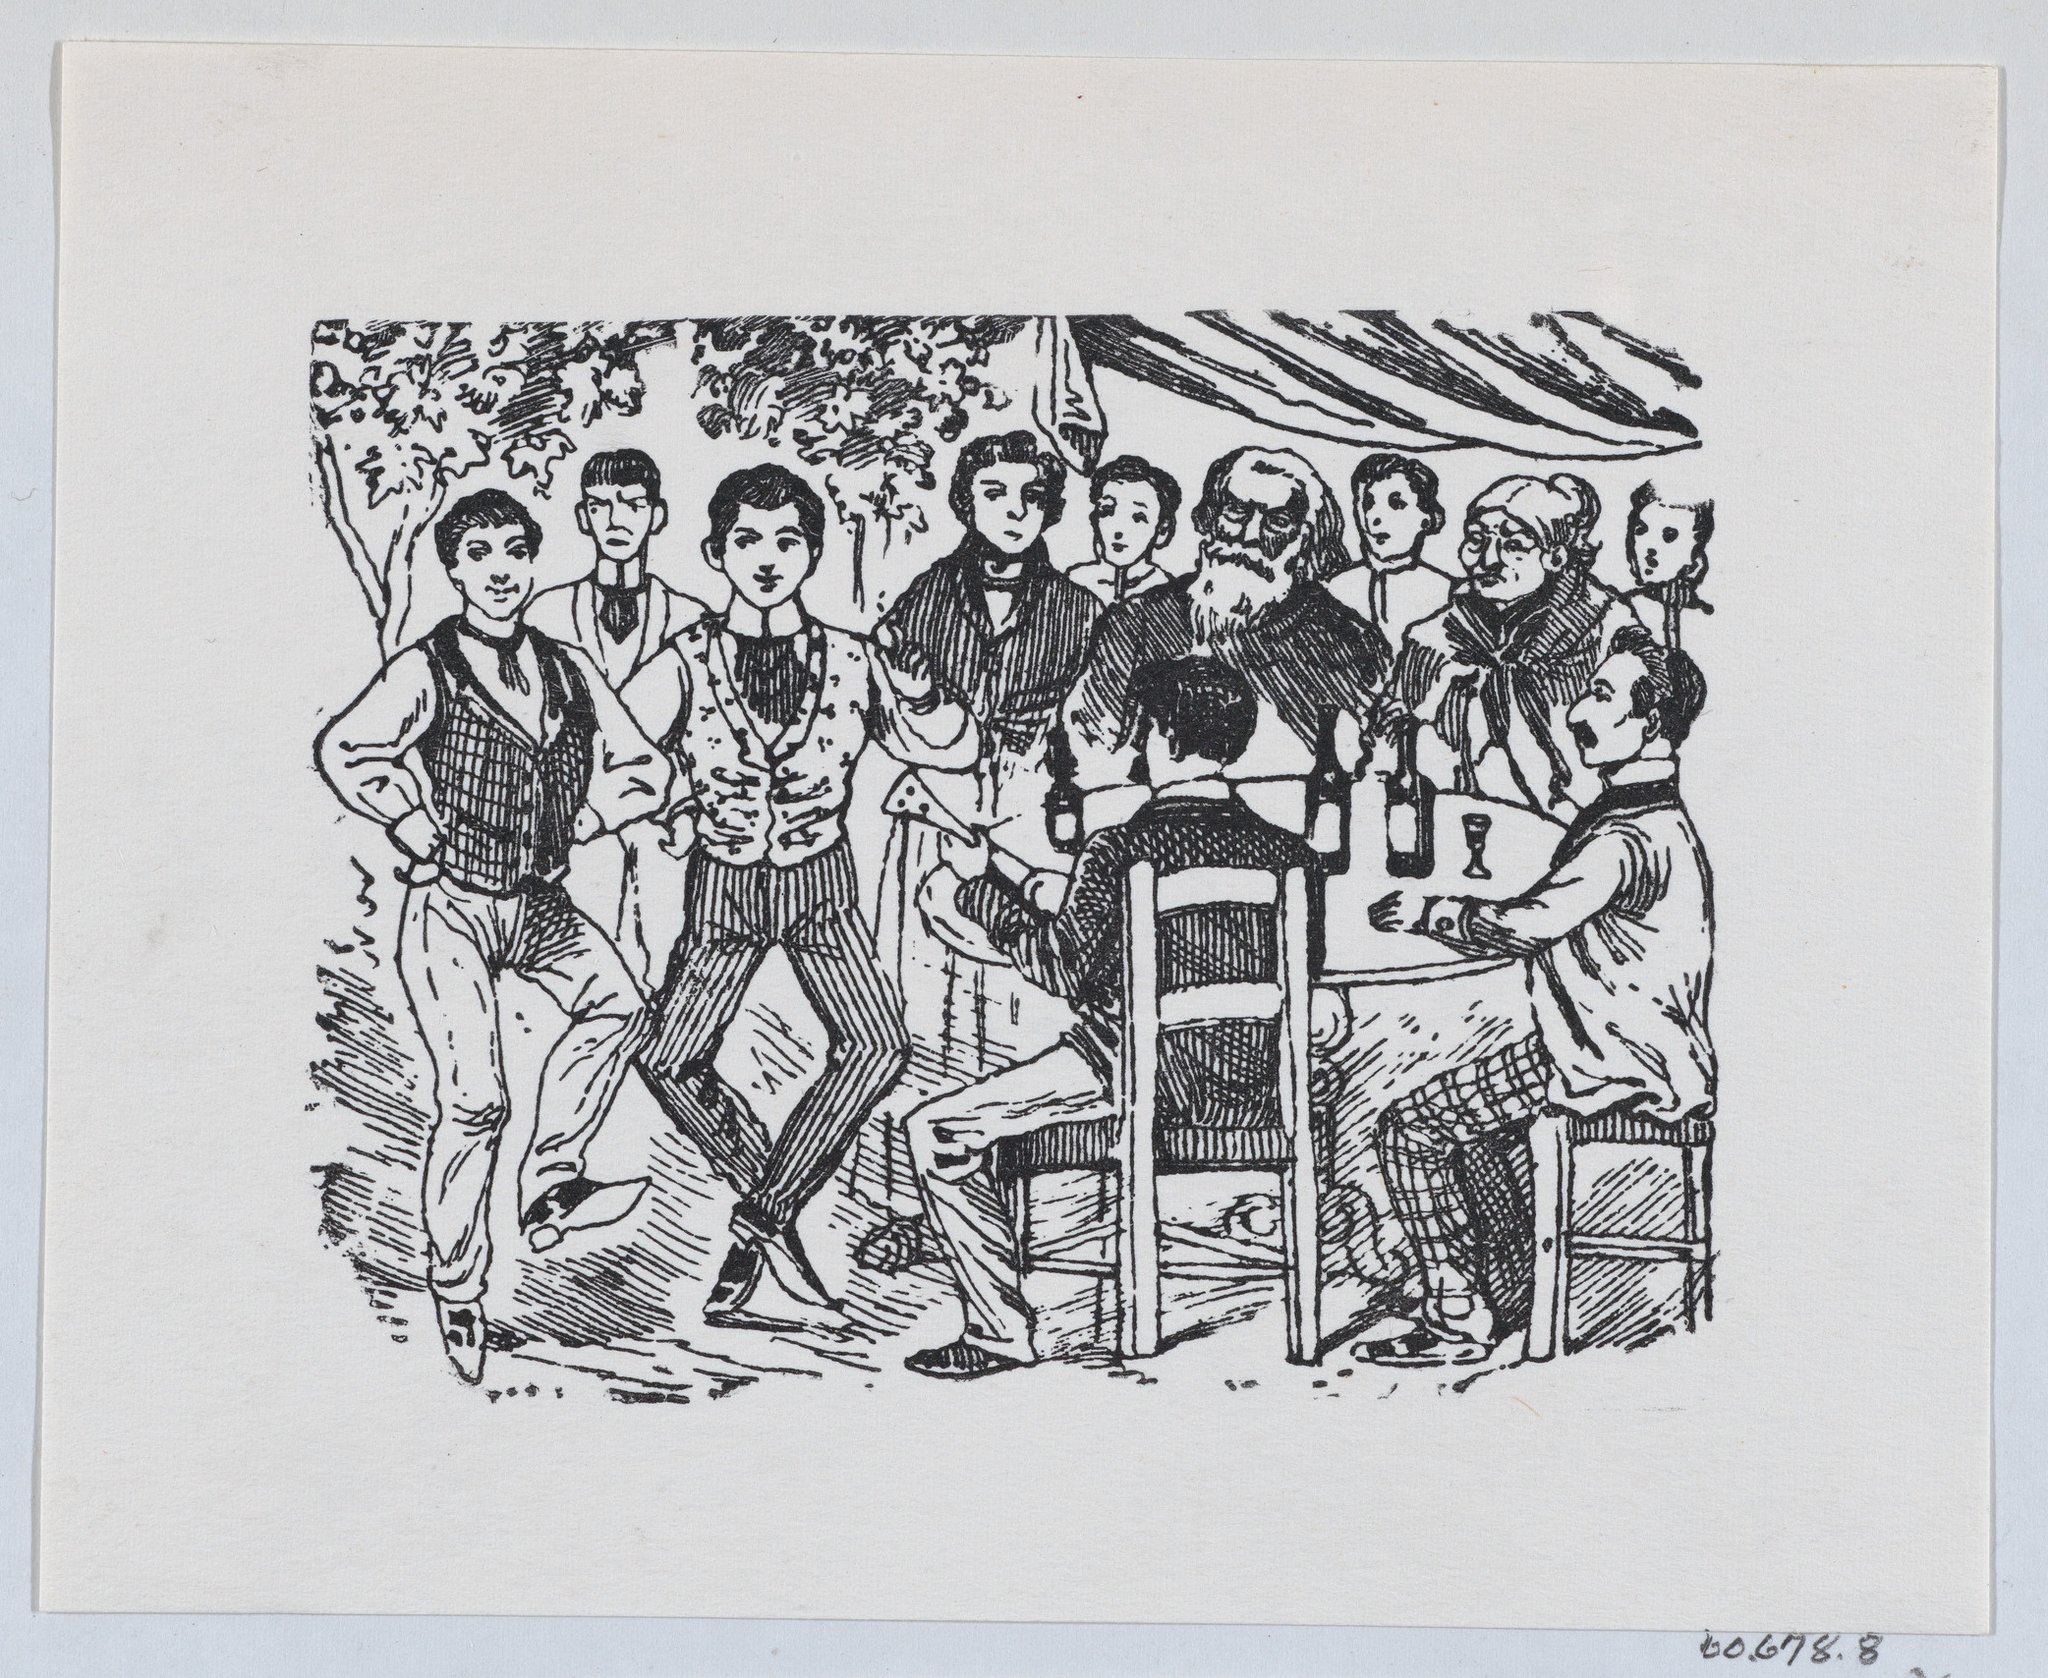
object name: print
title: A pair of young men dancing for a crowd of older people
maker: josé guadalupe posada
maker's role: artist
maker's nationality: mexican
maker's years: 1852-1913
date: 1880-1910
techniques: lithography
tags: men,dancing,crowd